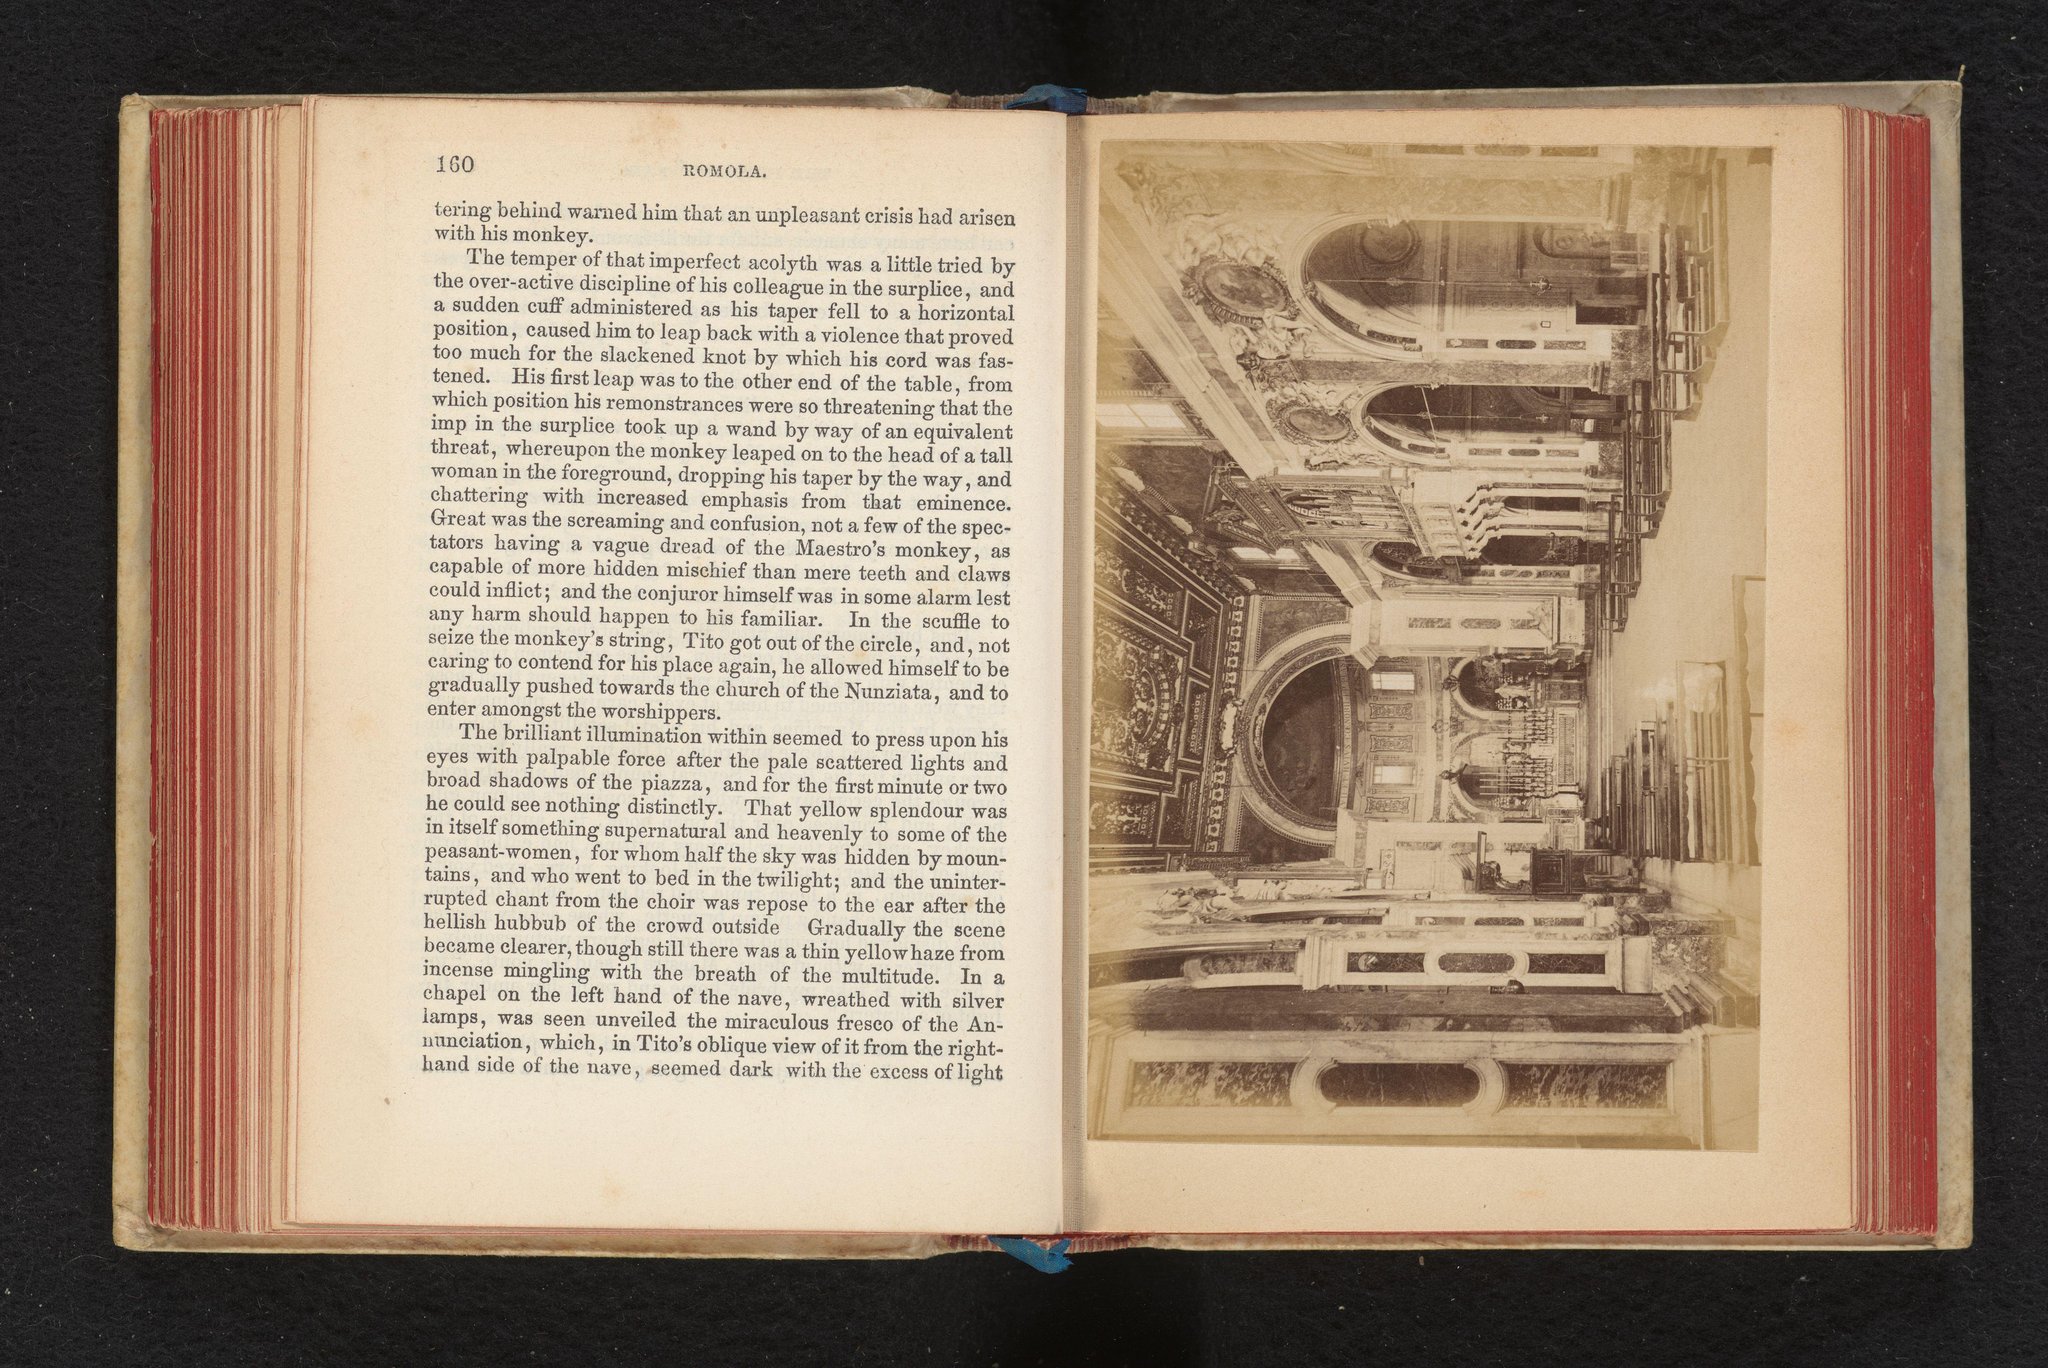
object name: page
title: Interieur van de Santissima Annunziata, Florence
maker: giacomo brogi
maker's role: fotograaf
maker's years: 1822-1881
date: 1858-1863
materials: paper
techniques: albumen print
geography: florence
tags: interior of church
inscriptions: name: ‘Brogi’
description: Foto op ongenummerde pagina tegenover pagina 160.